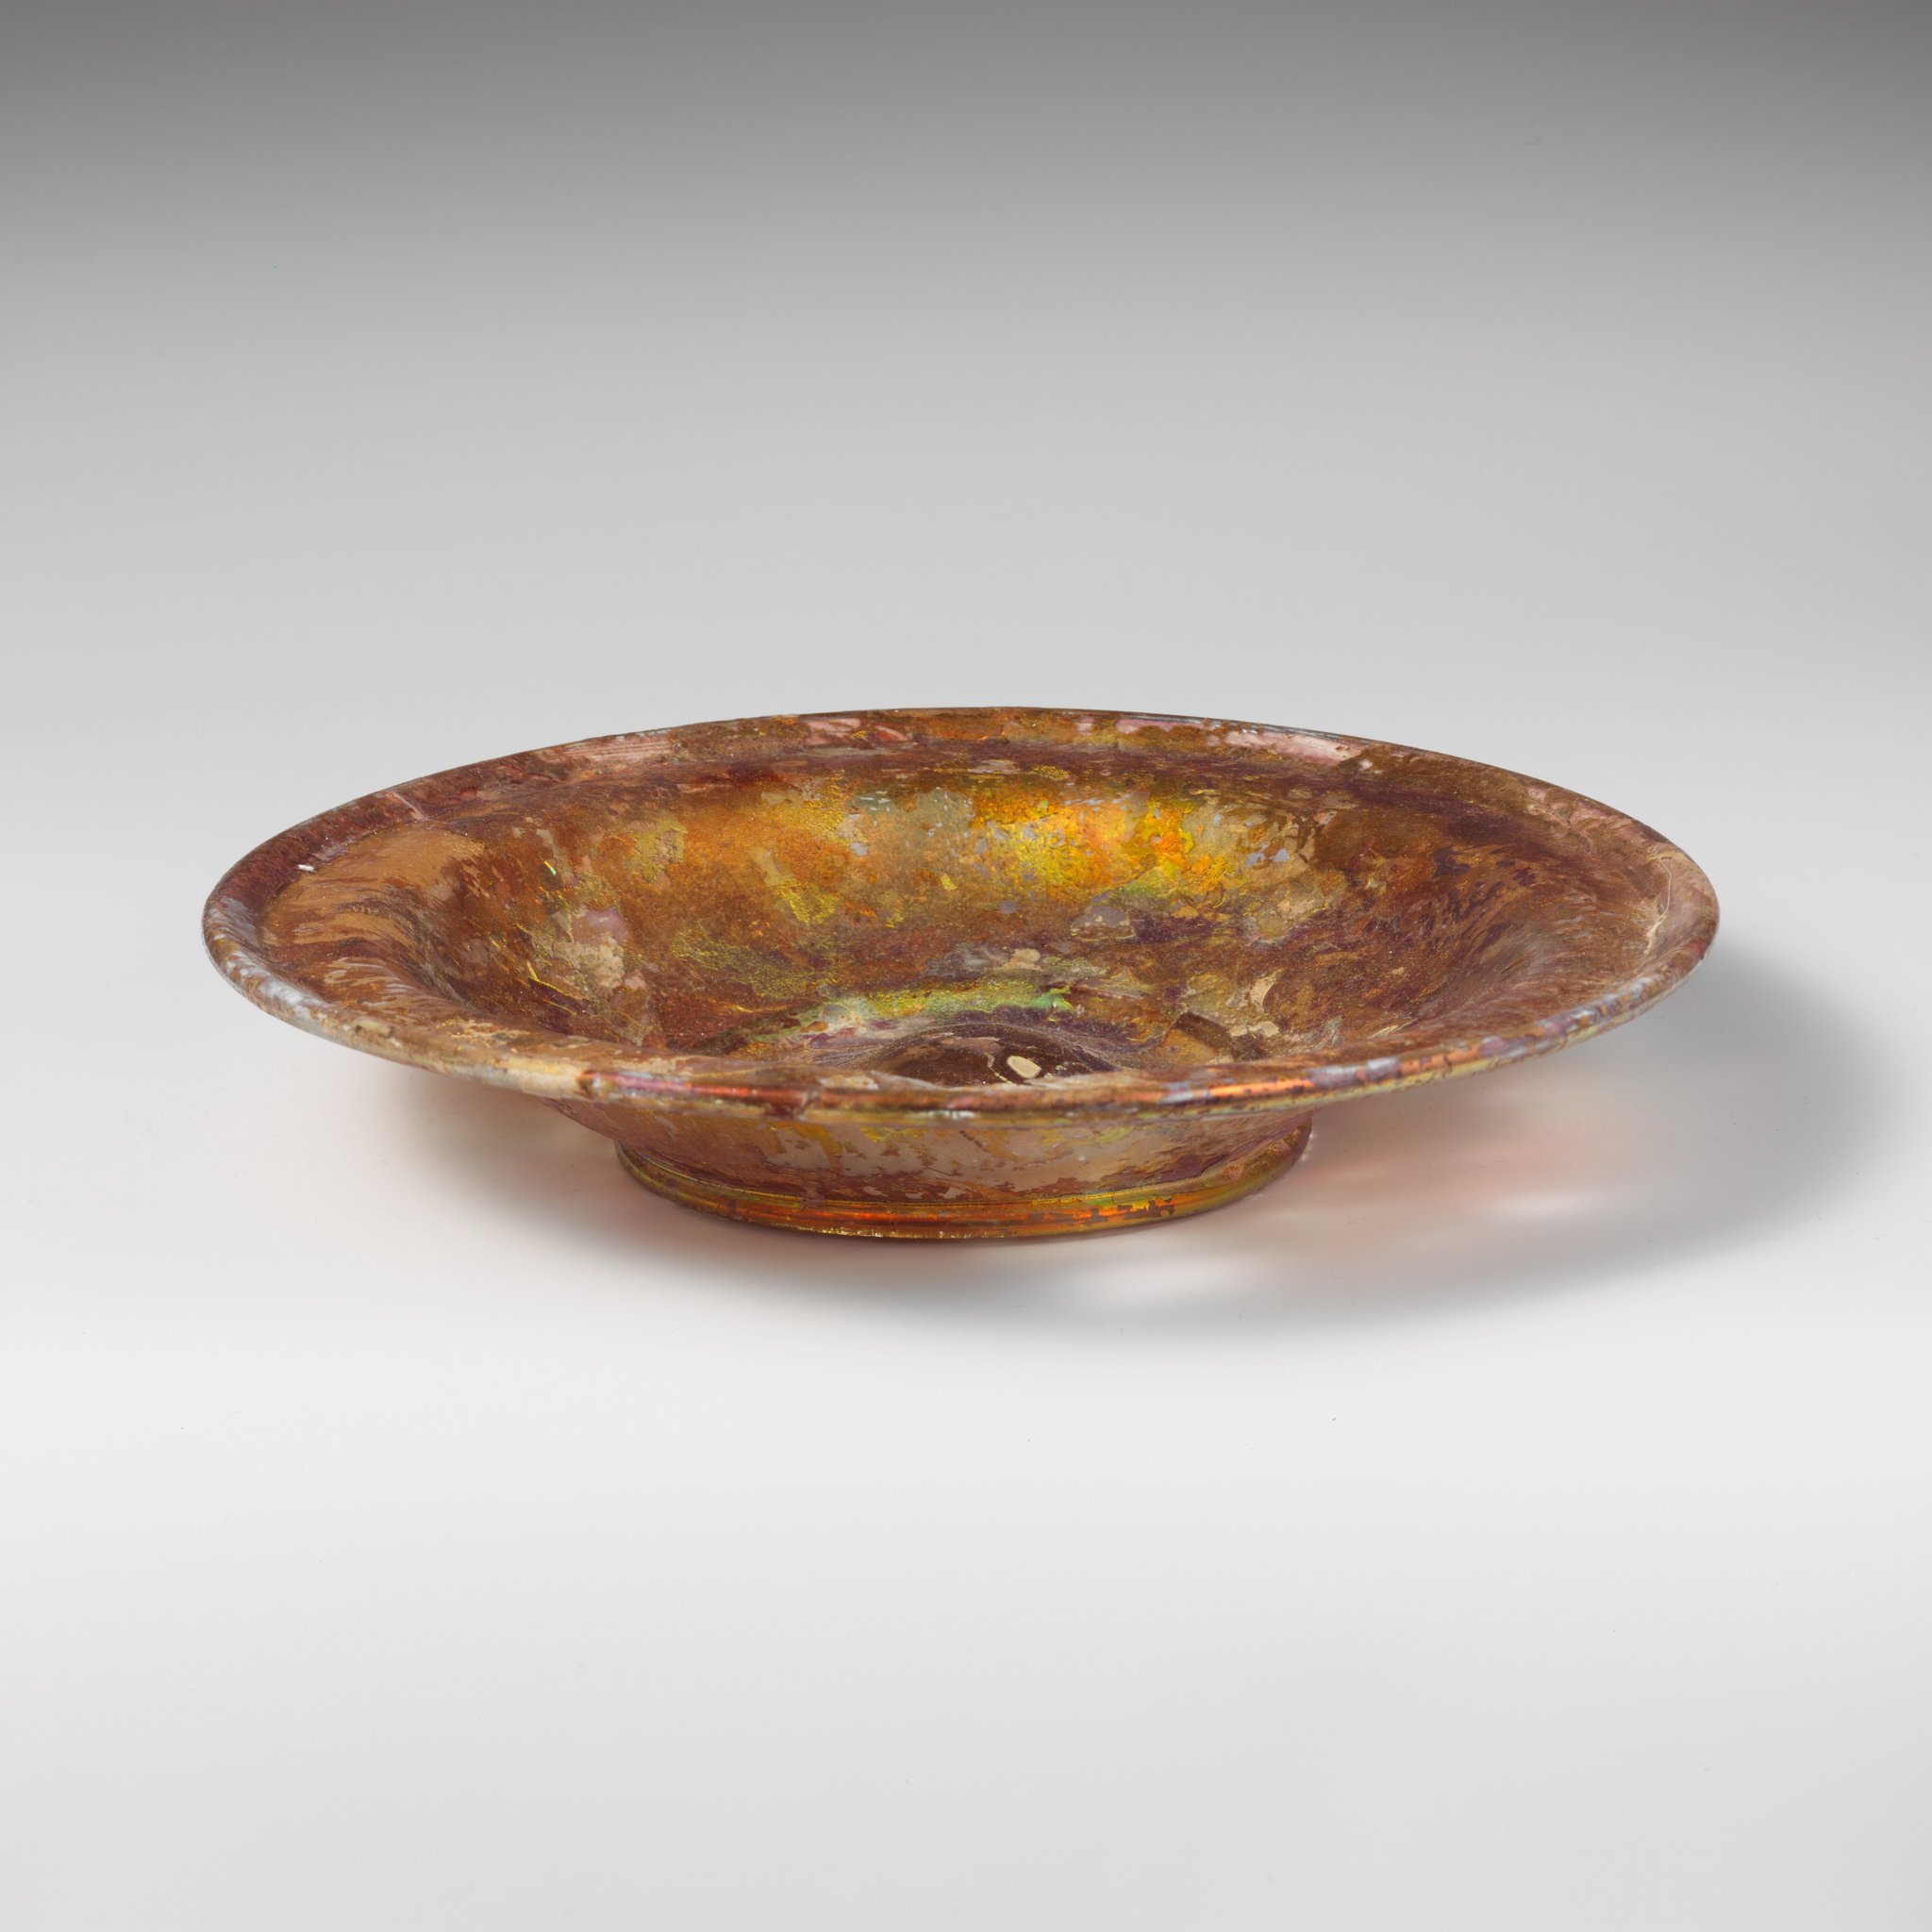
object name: dish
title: Glass dish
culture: roman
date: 301-500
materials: glass